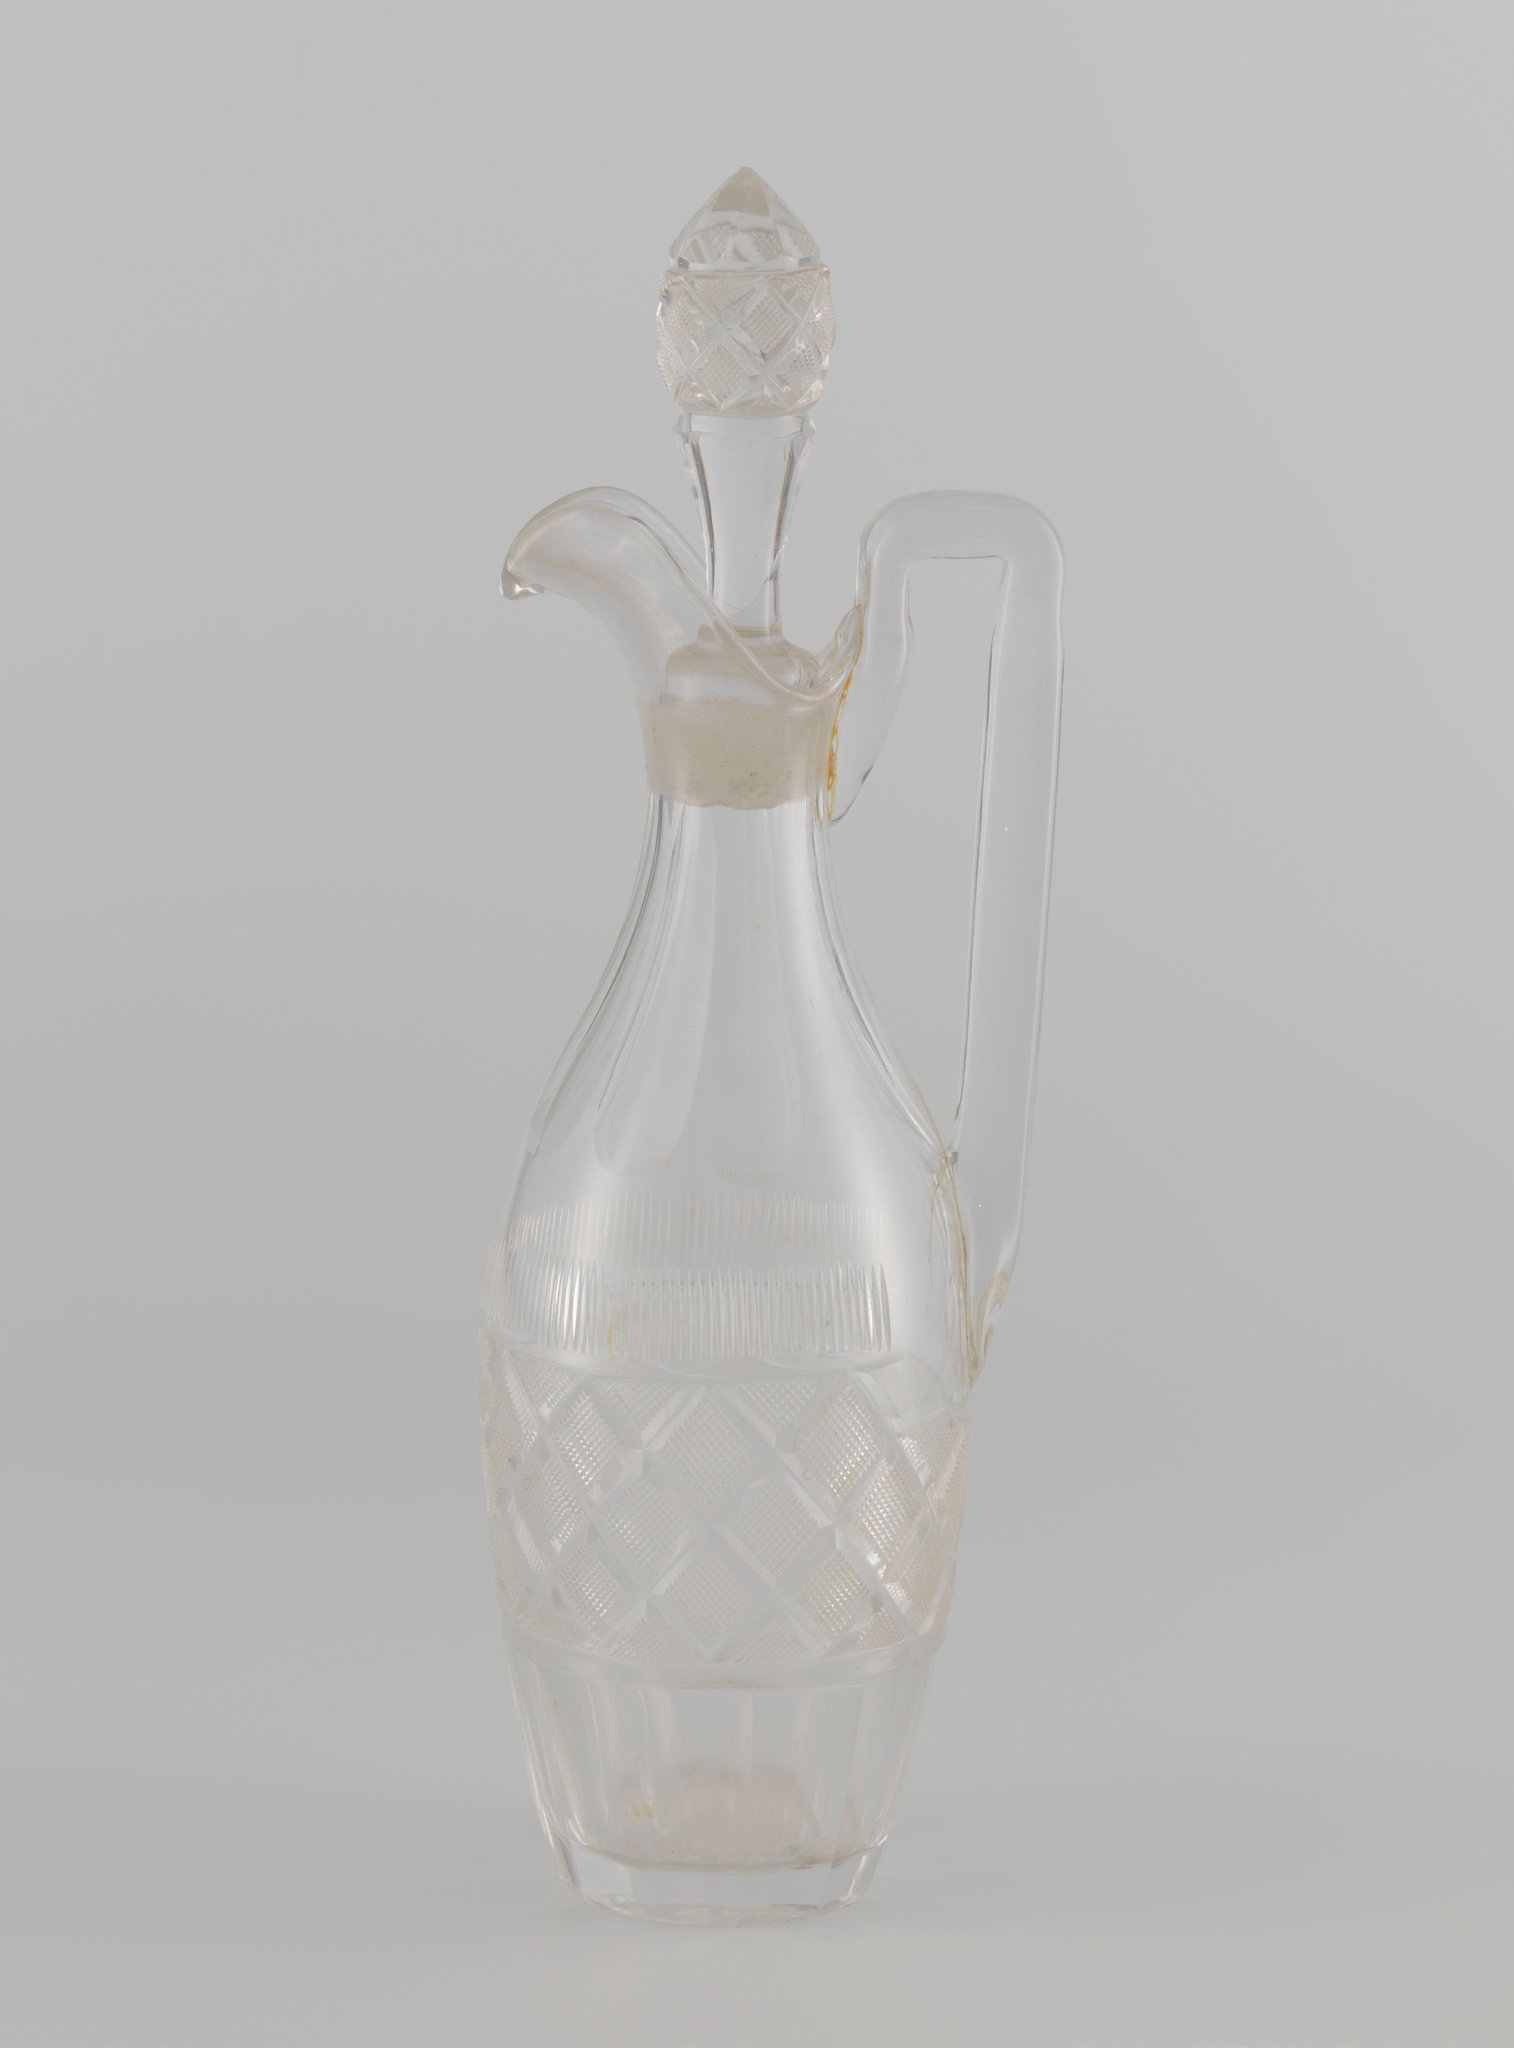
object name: bung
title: Stop van fles van olie- en azijnstel bestaande uit twee flessen van glas en een peperbus in een houder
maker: jan hendrik middelhuysen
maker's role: silversmith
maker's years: 1746-1822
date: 1783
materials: glass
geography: amsterdam